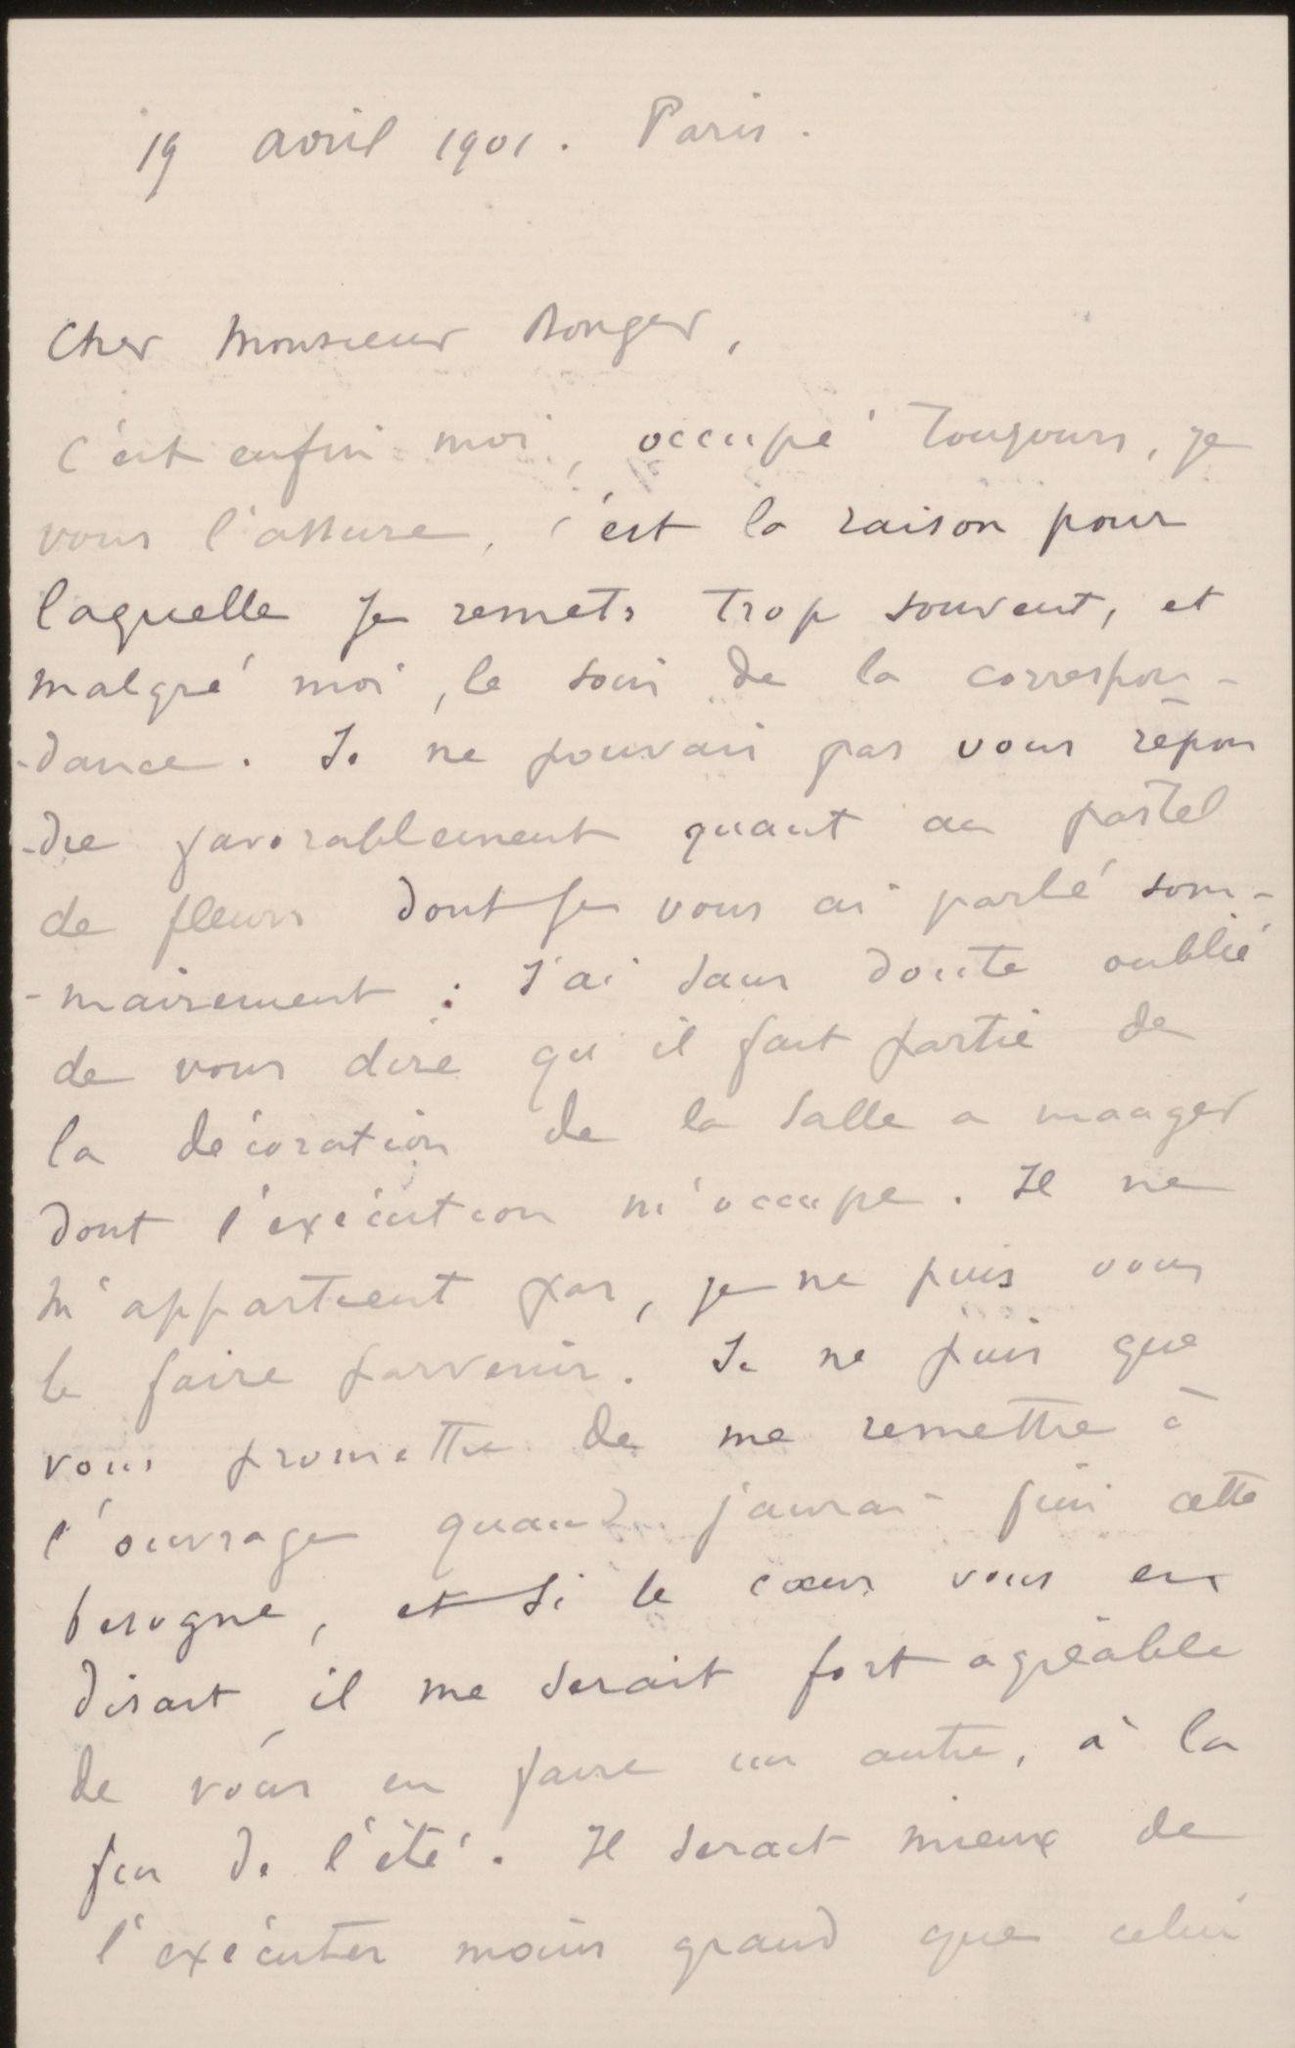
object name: letter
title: Brief aan Andries Bonger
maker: odilon redon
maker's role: draughtsman, painter, print maker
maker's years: 1840-1916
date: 1901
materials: ink, paper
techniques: pen, writing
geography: paris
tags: camille redon-falte, arï redon, painter, print maker, draughtsman, vincent van gogh, paul cézanne, andries bonger, stéphane mallarmé, drawing, applied arts, arts and crafts; industrial design, painting (including book-illumination, miniature-painting), exhibition ~ art, diseases, printed matter, brussels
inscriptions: watermark